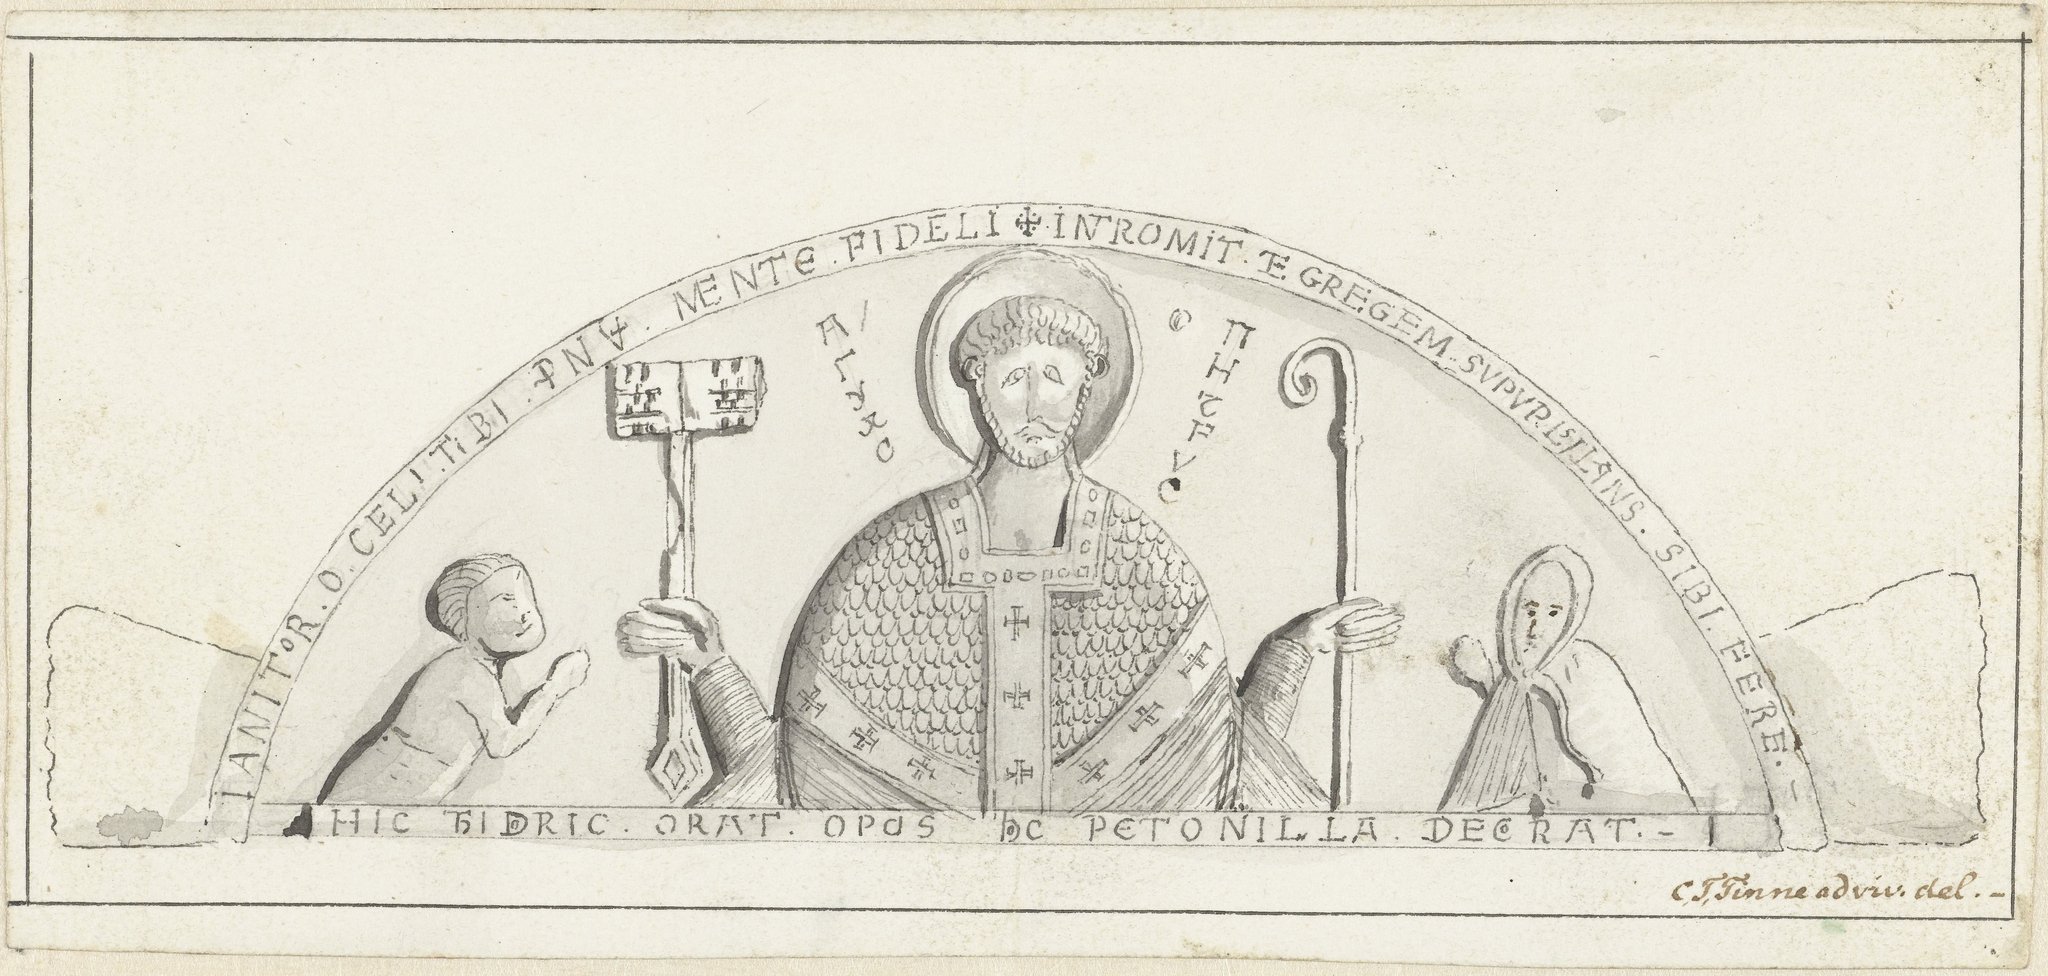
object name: drawing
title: Timpaan van de abdijkerk te Egmond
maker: chrétien théodore tinne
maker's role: draughtsman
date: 1802-1804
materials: ink, paper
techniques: brush, pen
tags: archbishop, bishop, etc. (roman catholic), piece of sculpture, reproduction of a piece of sculpture, the apostle peter, first bishop of rome; possible attributes: book, cock, (upturned) cross, (triple) crozier, fish, key, scroll, ship, tiara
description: Timpaan van Egmond: boogtrommel met Petrus, graaf Dirk VI van Holland en zijn moeder gravin Petronella. Het geheel omringd met Latijnse inscripties. De steen is afkomstig uit de voormalige Benedictijner Abdij van St. Petrus en St. Adelbert te Egmond-Binnen. Onder de steen enkele oude letters. FM plaatst de voorstellingen van deze steen in het jaar 1009, in werkelijkheid is de steen vervaardigd ca. 1120.